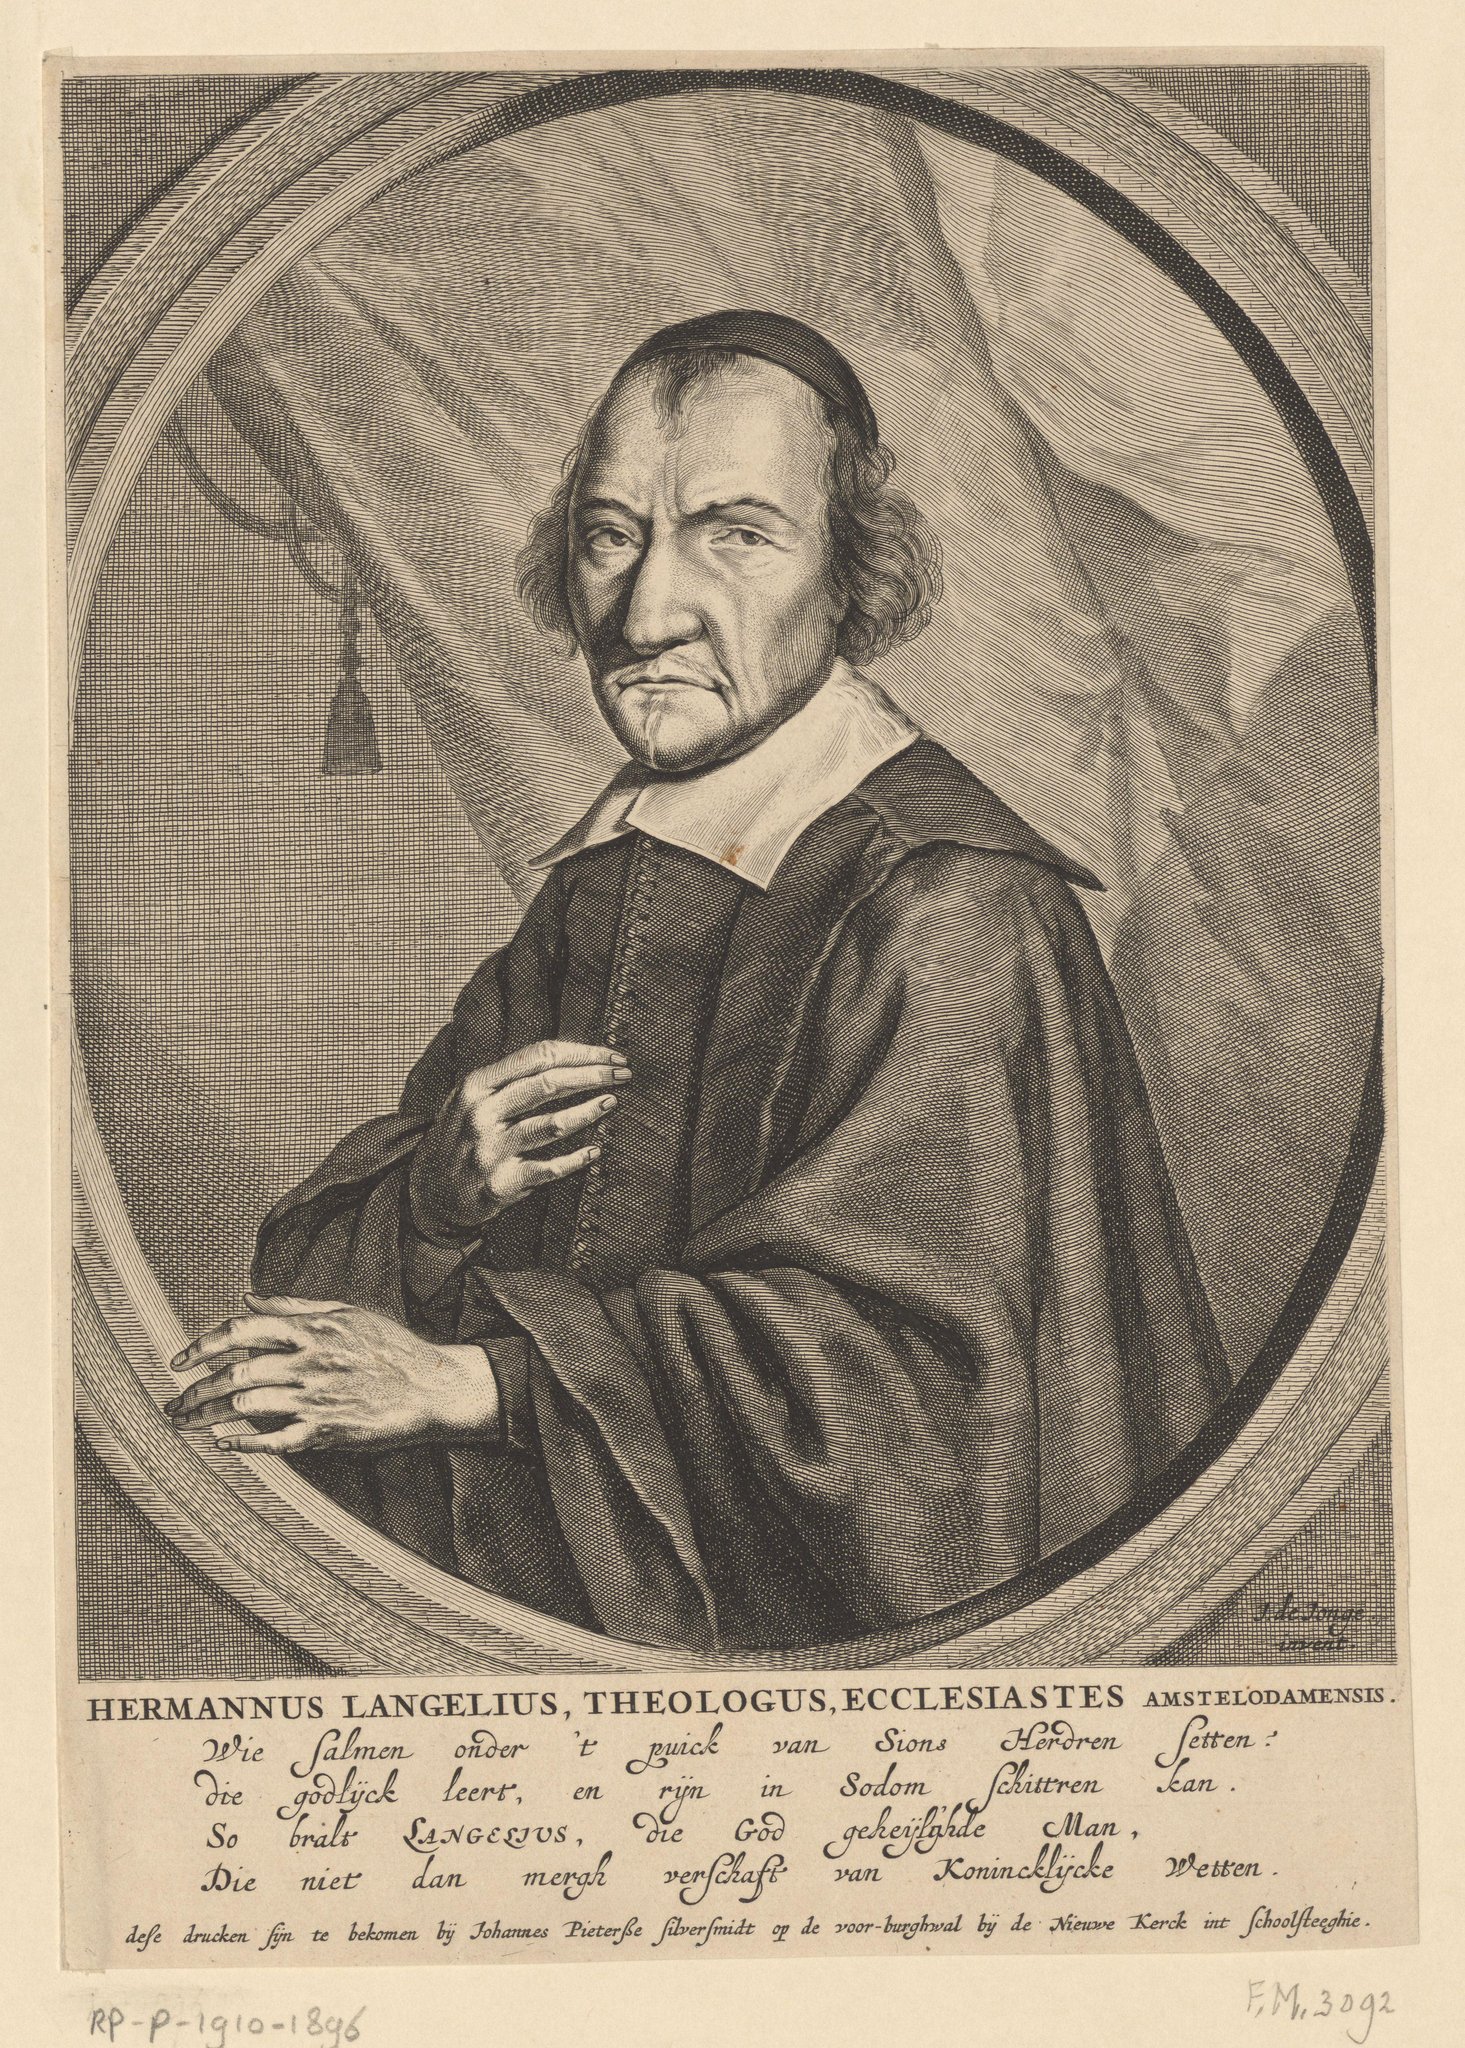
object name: print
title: Portret van Hermanus Langelius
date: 1655-1699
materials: paper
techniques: engraving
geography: amsterdam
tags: historical persons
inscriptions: collector's mark: Lugt 2228